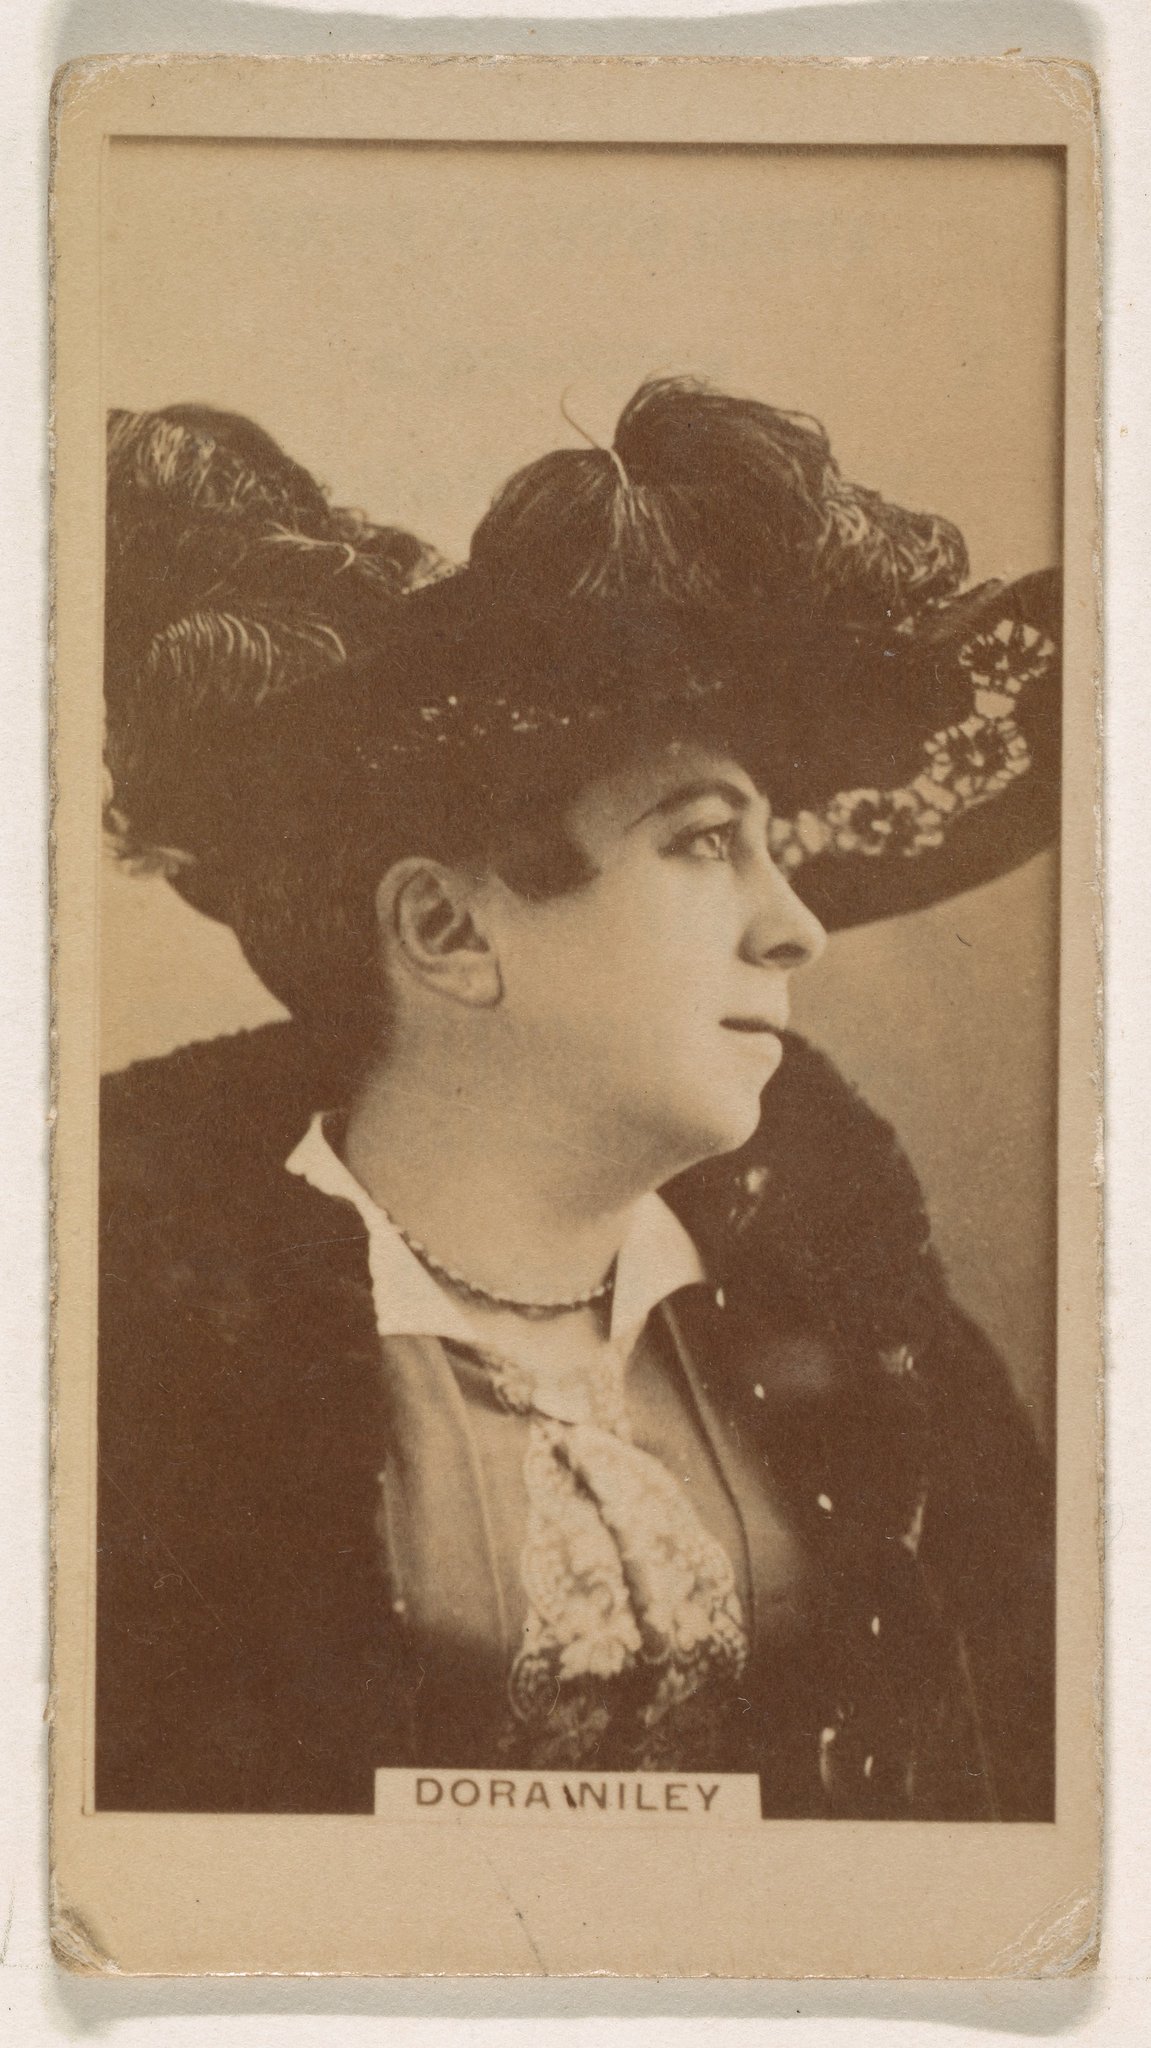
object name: photograph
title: Dora Wiley, from the Actresses series (N245) issued by Kinney Brothers to promote Sweet Caporal Cigarettes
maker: kinney brothers tobacco company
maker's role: publisher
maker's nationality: american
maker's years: 1869-2011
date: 1890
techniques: albumen silver print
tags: women,actresses